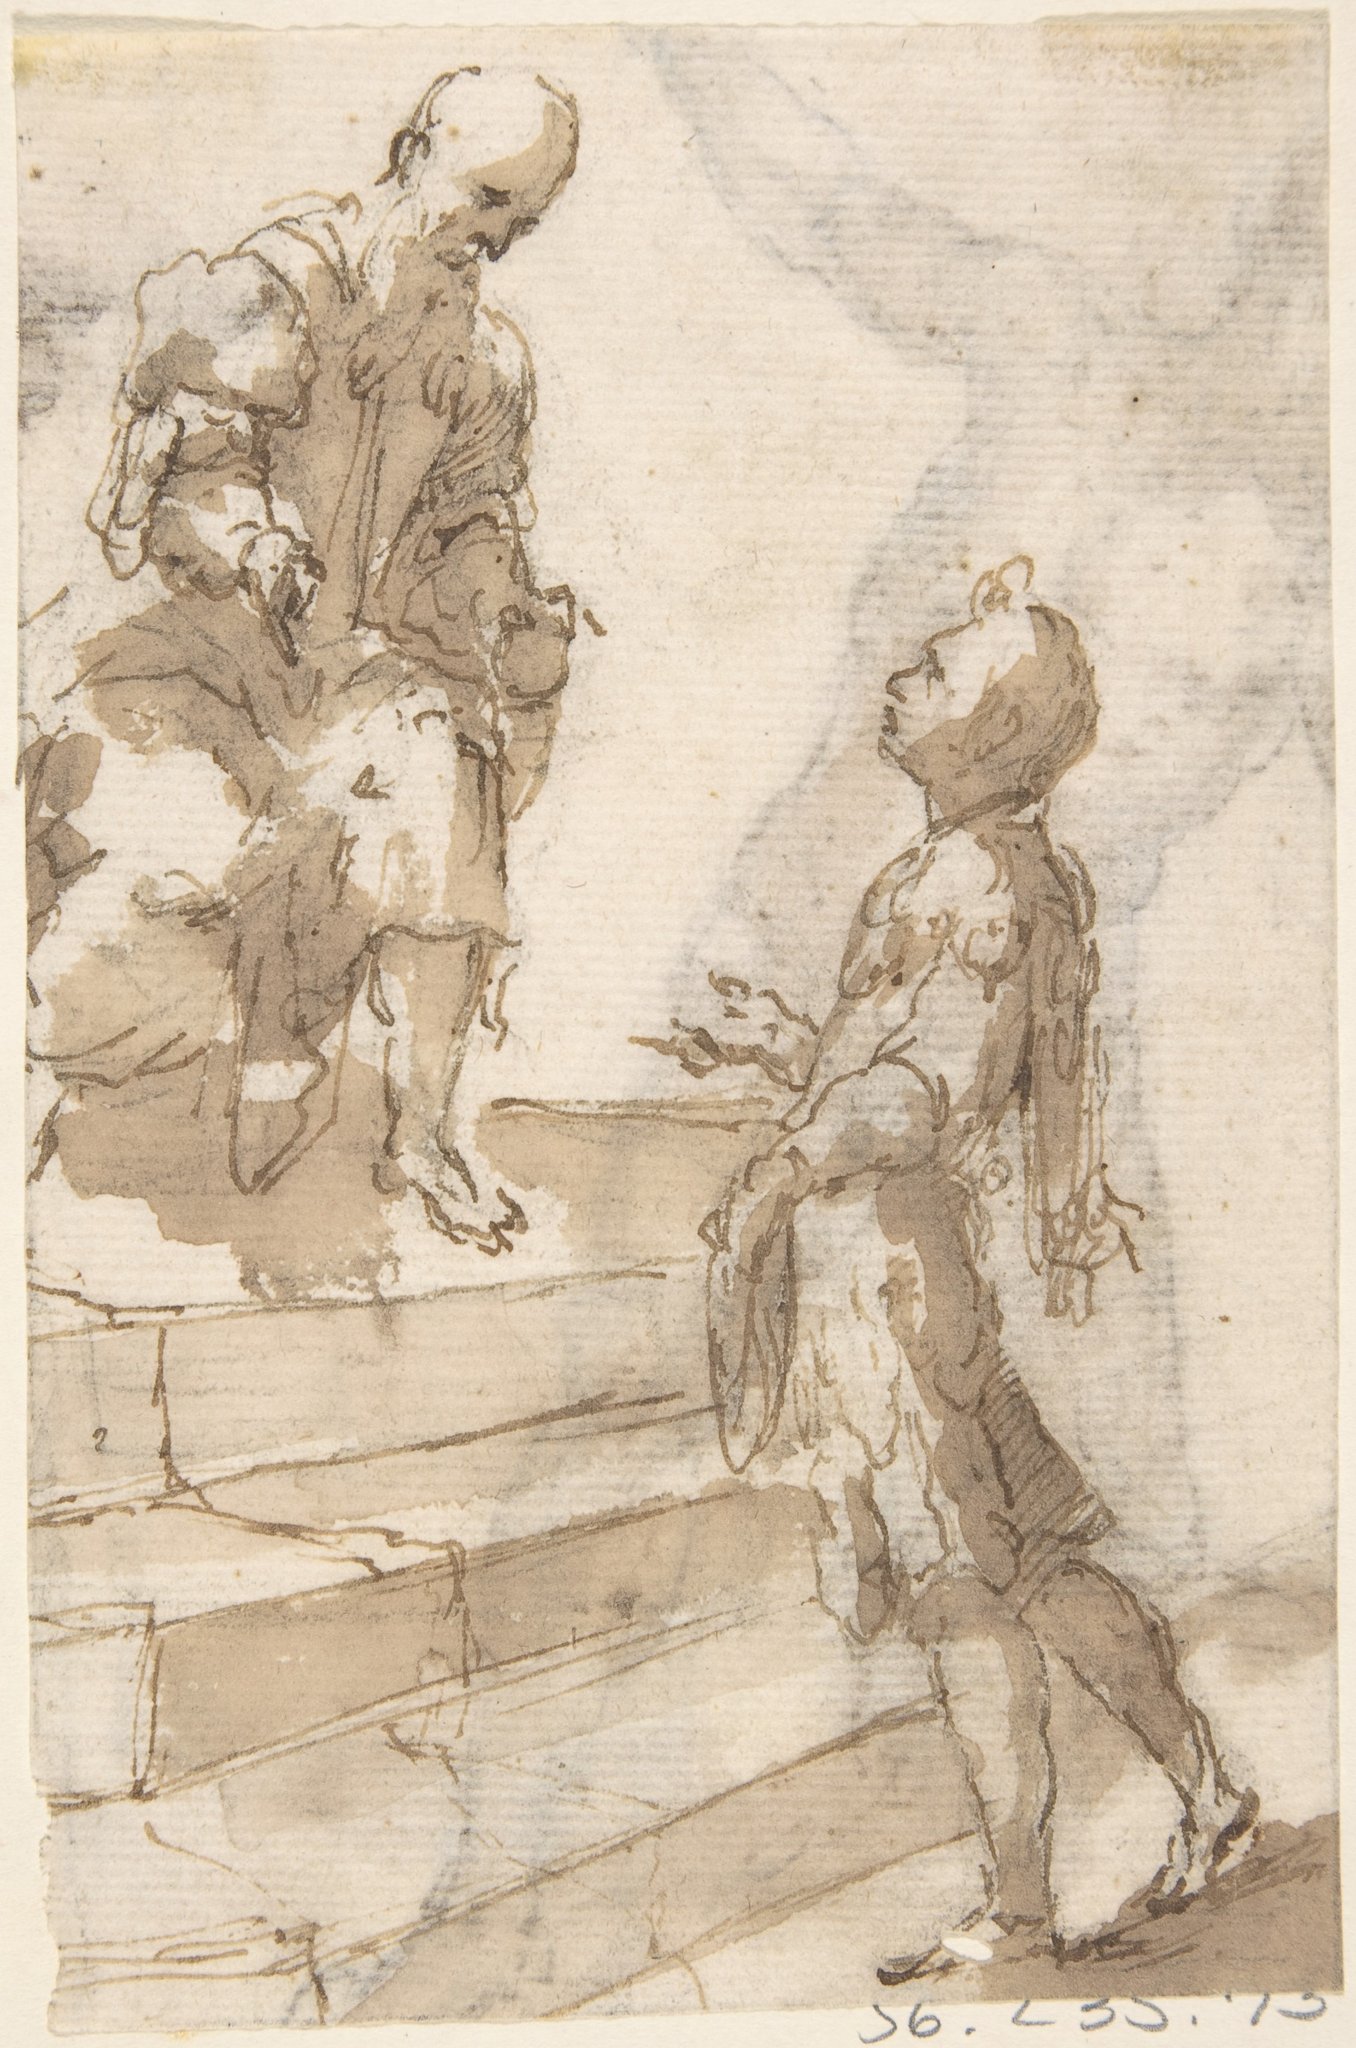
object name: drawing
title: Young Man Approaching Old Bearded Man Who Stands on Steps (recto); Male Nude with Bent Right Knee (verso)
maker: anonymous, spanish, school of seville, 17th century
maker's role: artist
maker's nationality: spanish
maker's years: 1600-1700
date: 1601-1700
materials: chalk, ink, paper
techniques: brush, pen, drawing, wash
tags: men